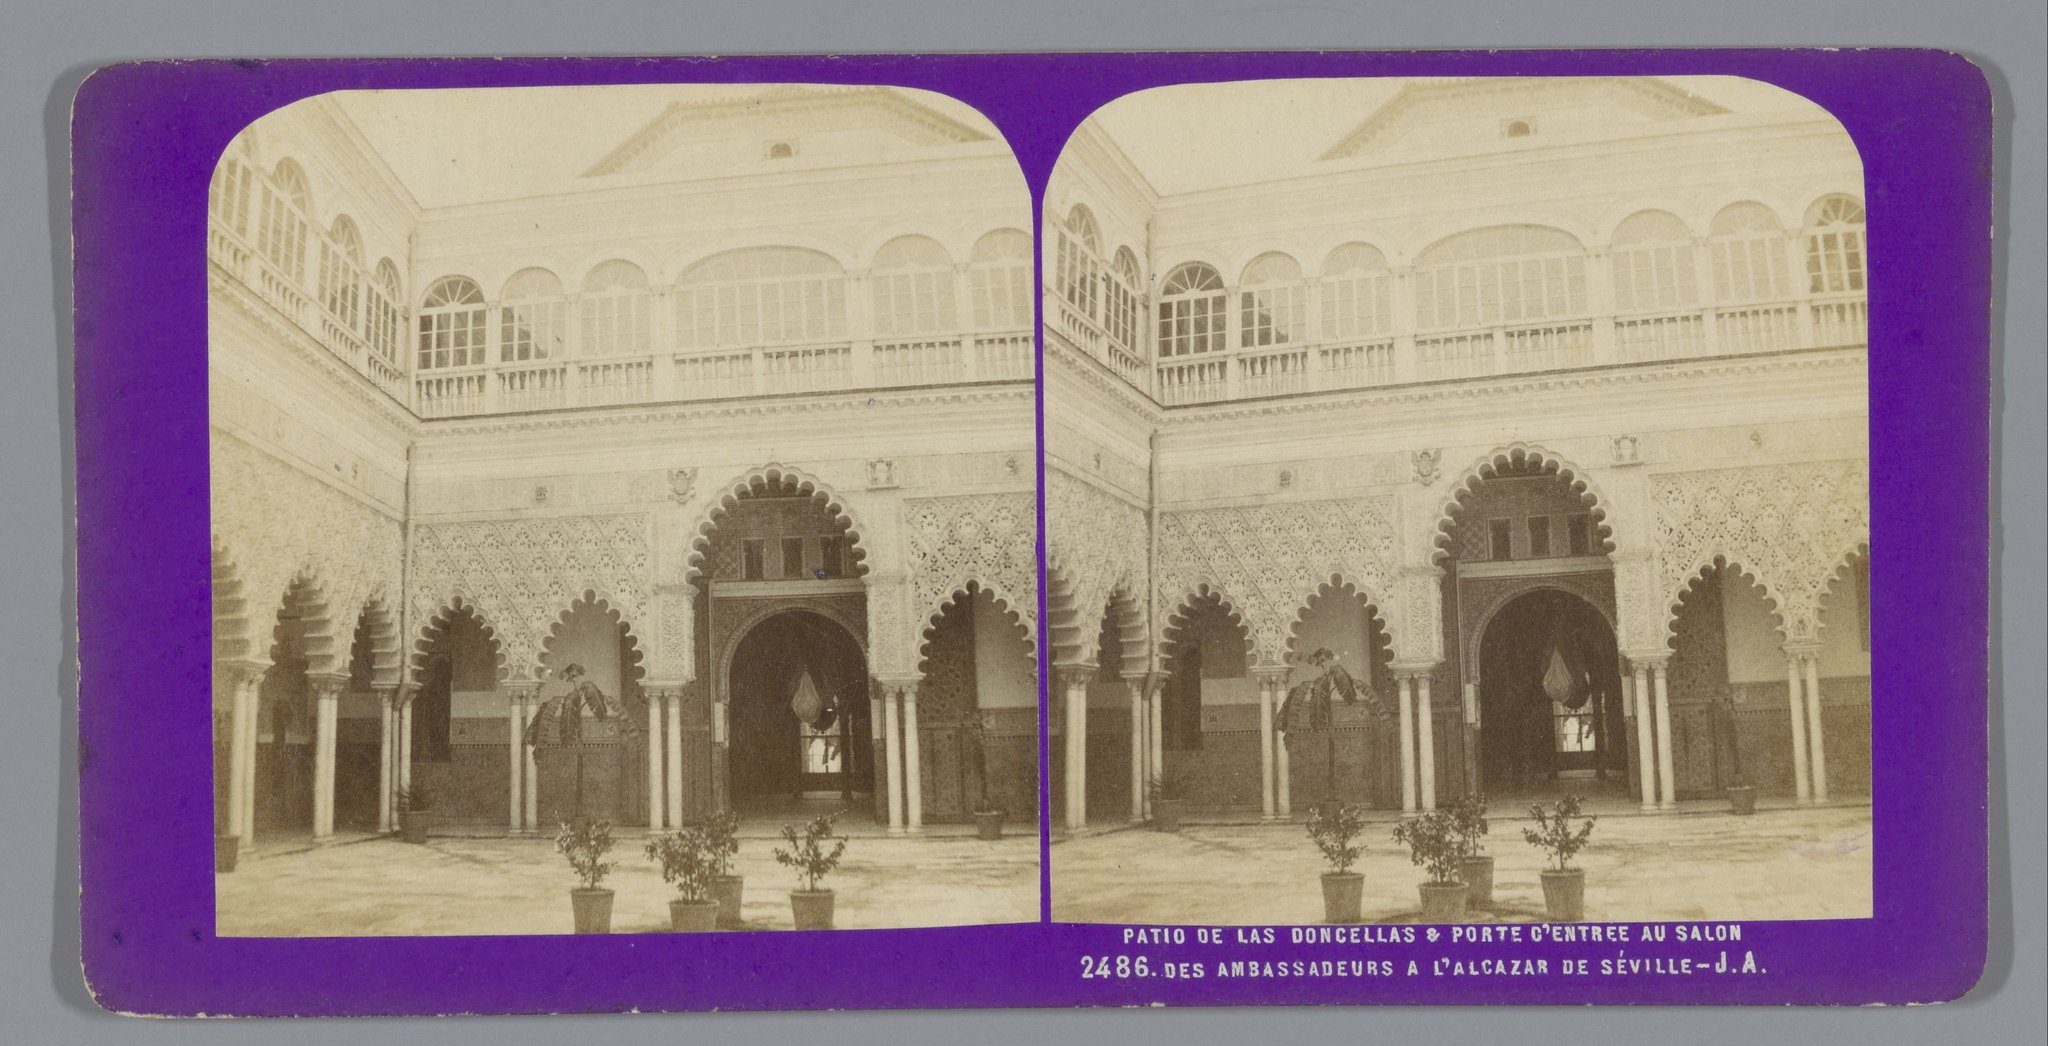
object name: stereograph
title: Gezicht op de Patio de las Doncellas en de poort van de Salón de Embajadores in het Alcazar in Sevilla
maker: jean andrieu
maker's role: fotograaf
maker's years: 1816-1872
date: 1862-1876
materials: cardboard, photographic support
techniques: albumen print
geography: royal palace of seville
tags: arch, archivolt ~ architecture, courtyard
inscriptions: number: ‘2486.’